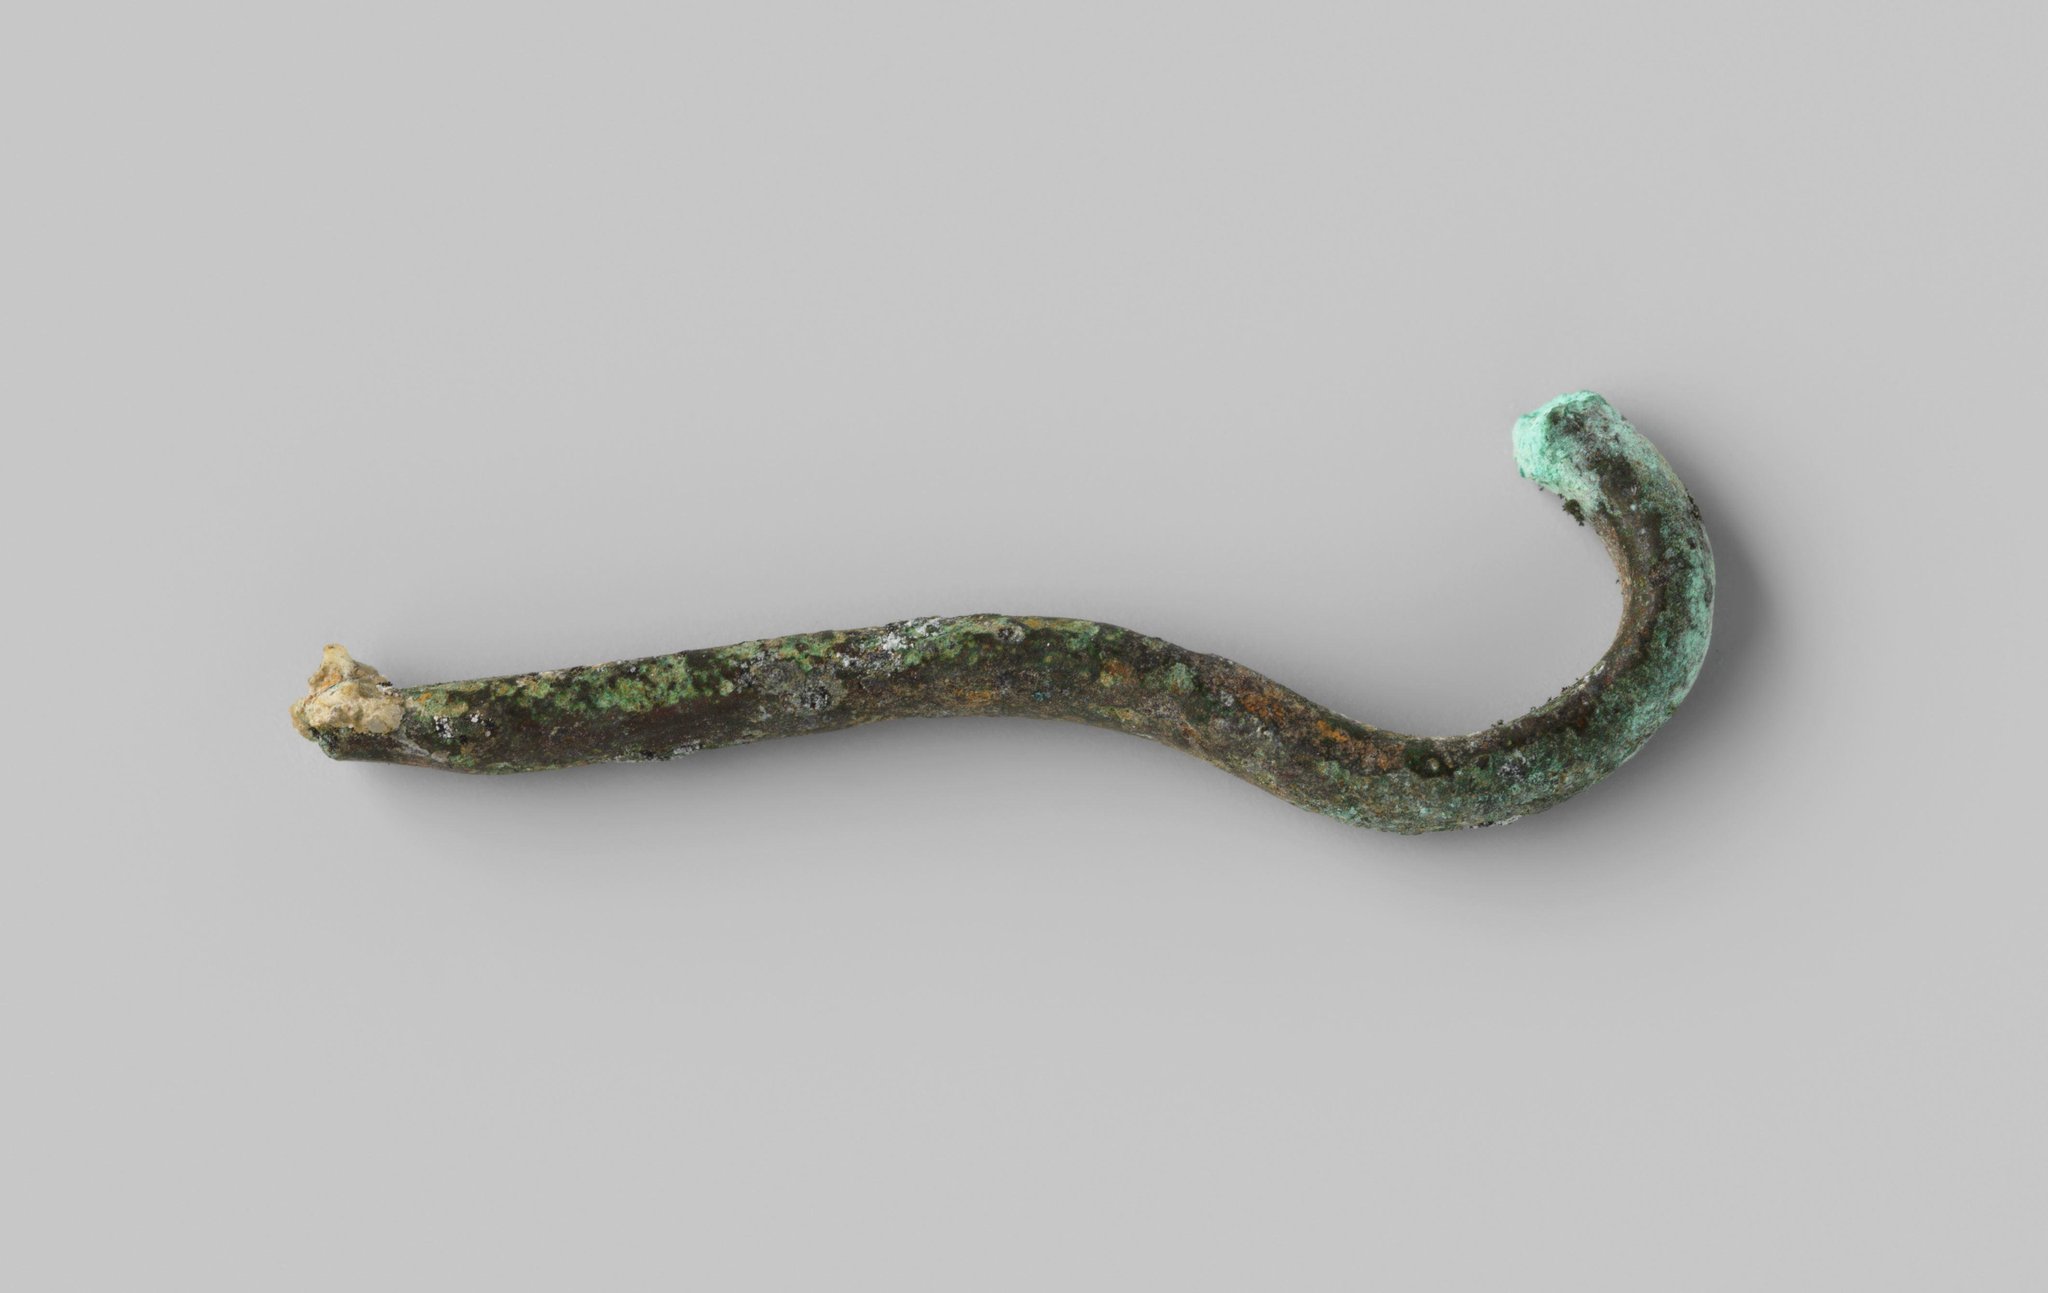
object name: spike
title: Pin van een gesp uit het wrak van de Oost-Indiëvaarder Hollandia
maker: Anonymous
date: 1700-1743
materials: copper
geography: netherlands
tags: verenigde oostindische compagnie, hollandia (schip), annet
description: Buckle, tongue; fragm, id. NG 1980-27H75.